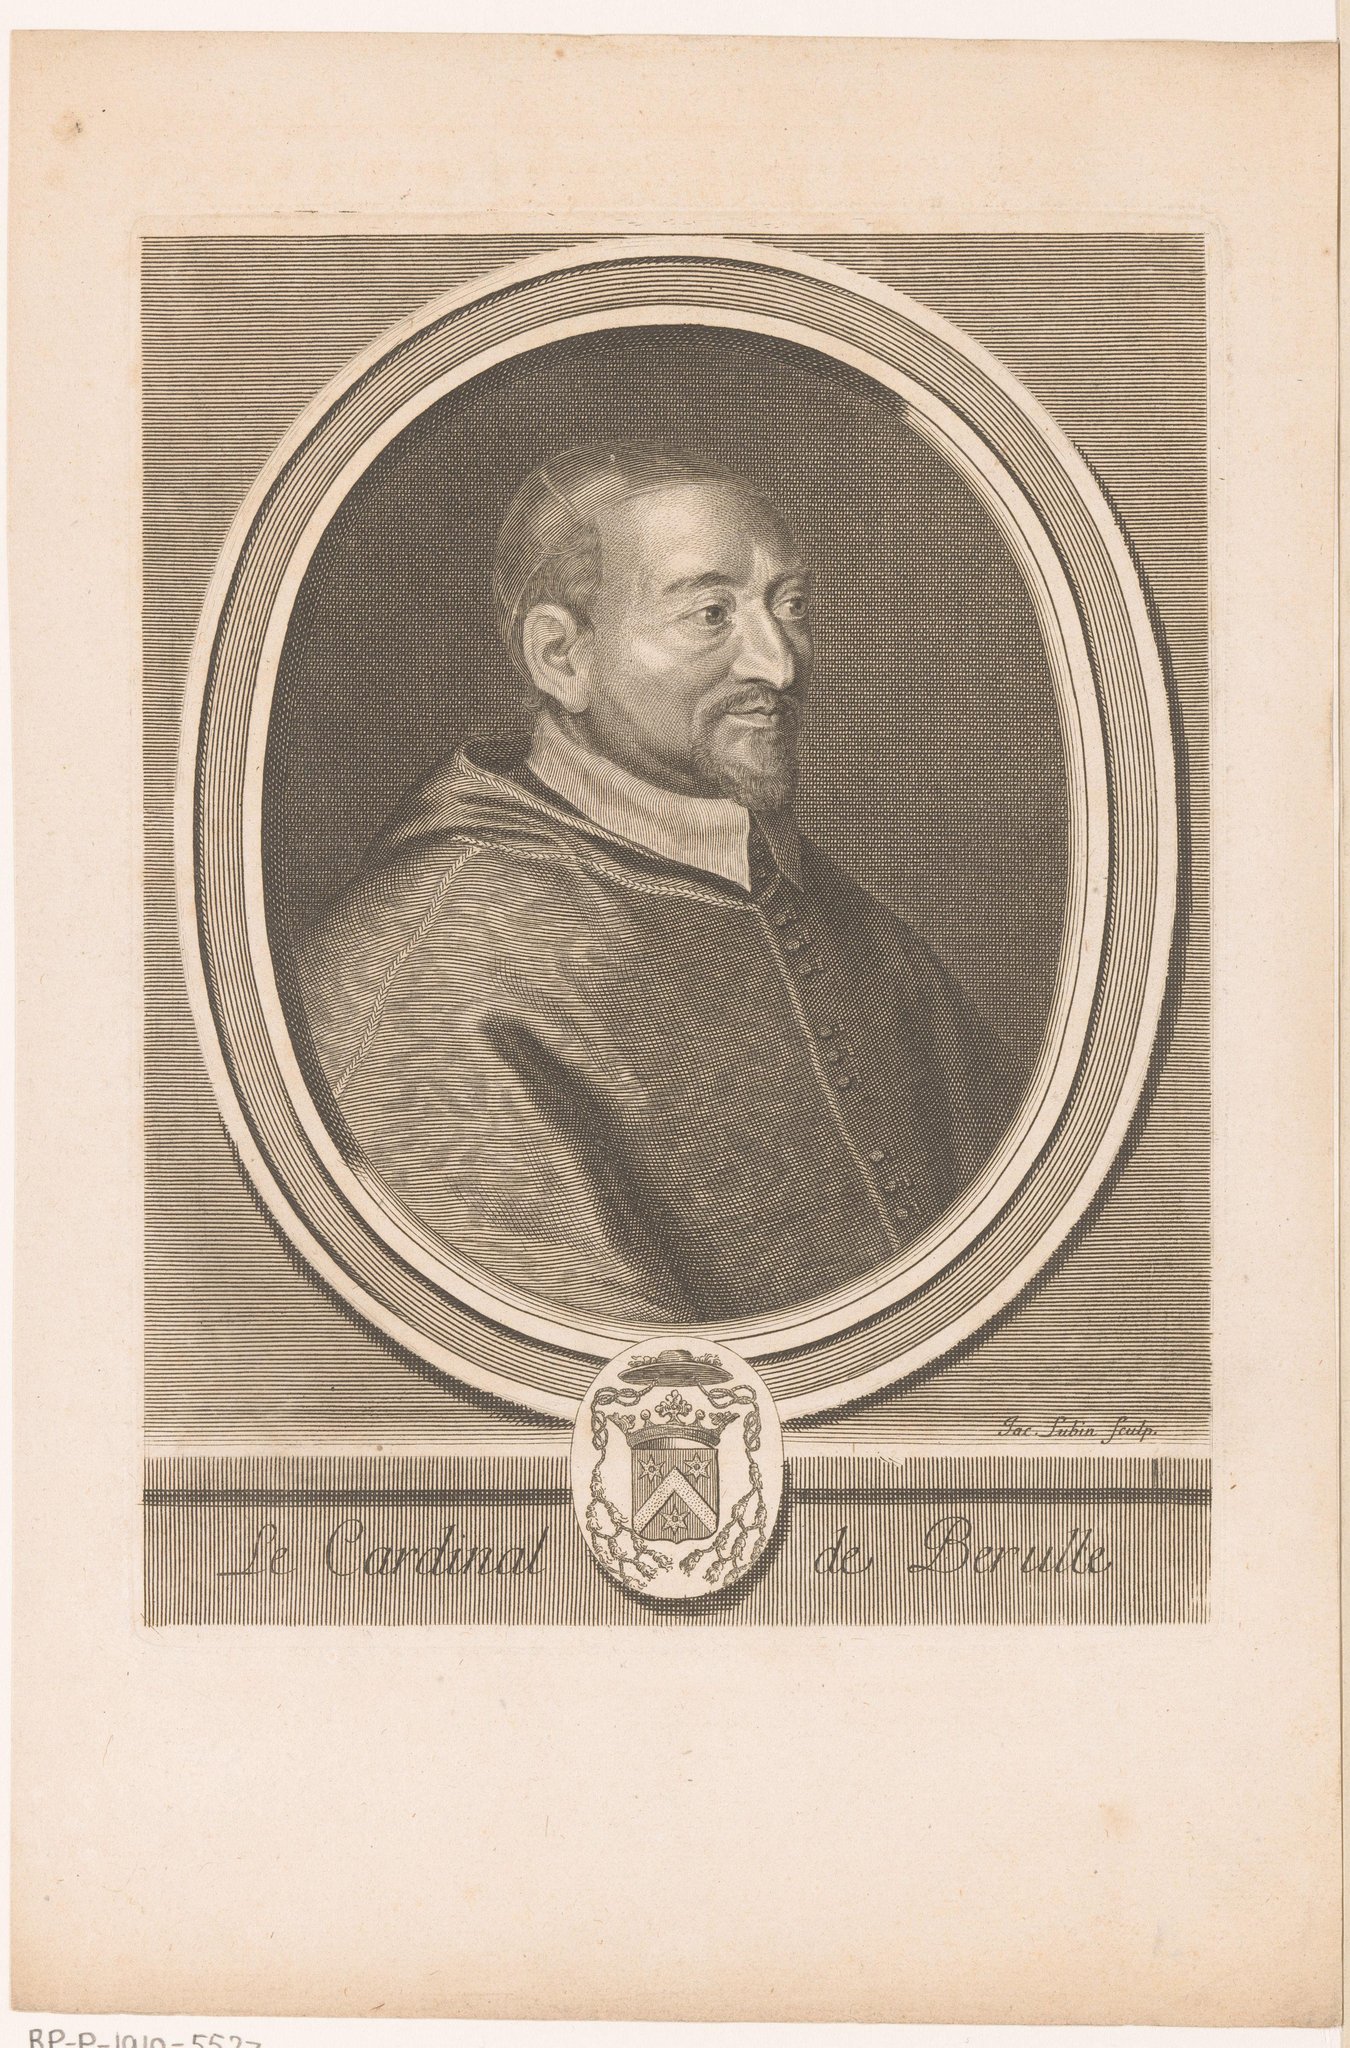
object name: print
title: Portret van Pierre de Bérulle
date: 1696-1700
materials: paper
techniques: engraving, etching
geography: paris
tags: cardinal, historical persons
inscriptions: collector's mark: Lugt 2228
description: Prent uit: Perrault, Charles. Les hommes illustres qui ont paru en France pendant ce siècle. Parijs: Antoine Dezallier, 1696-1700.